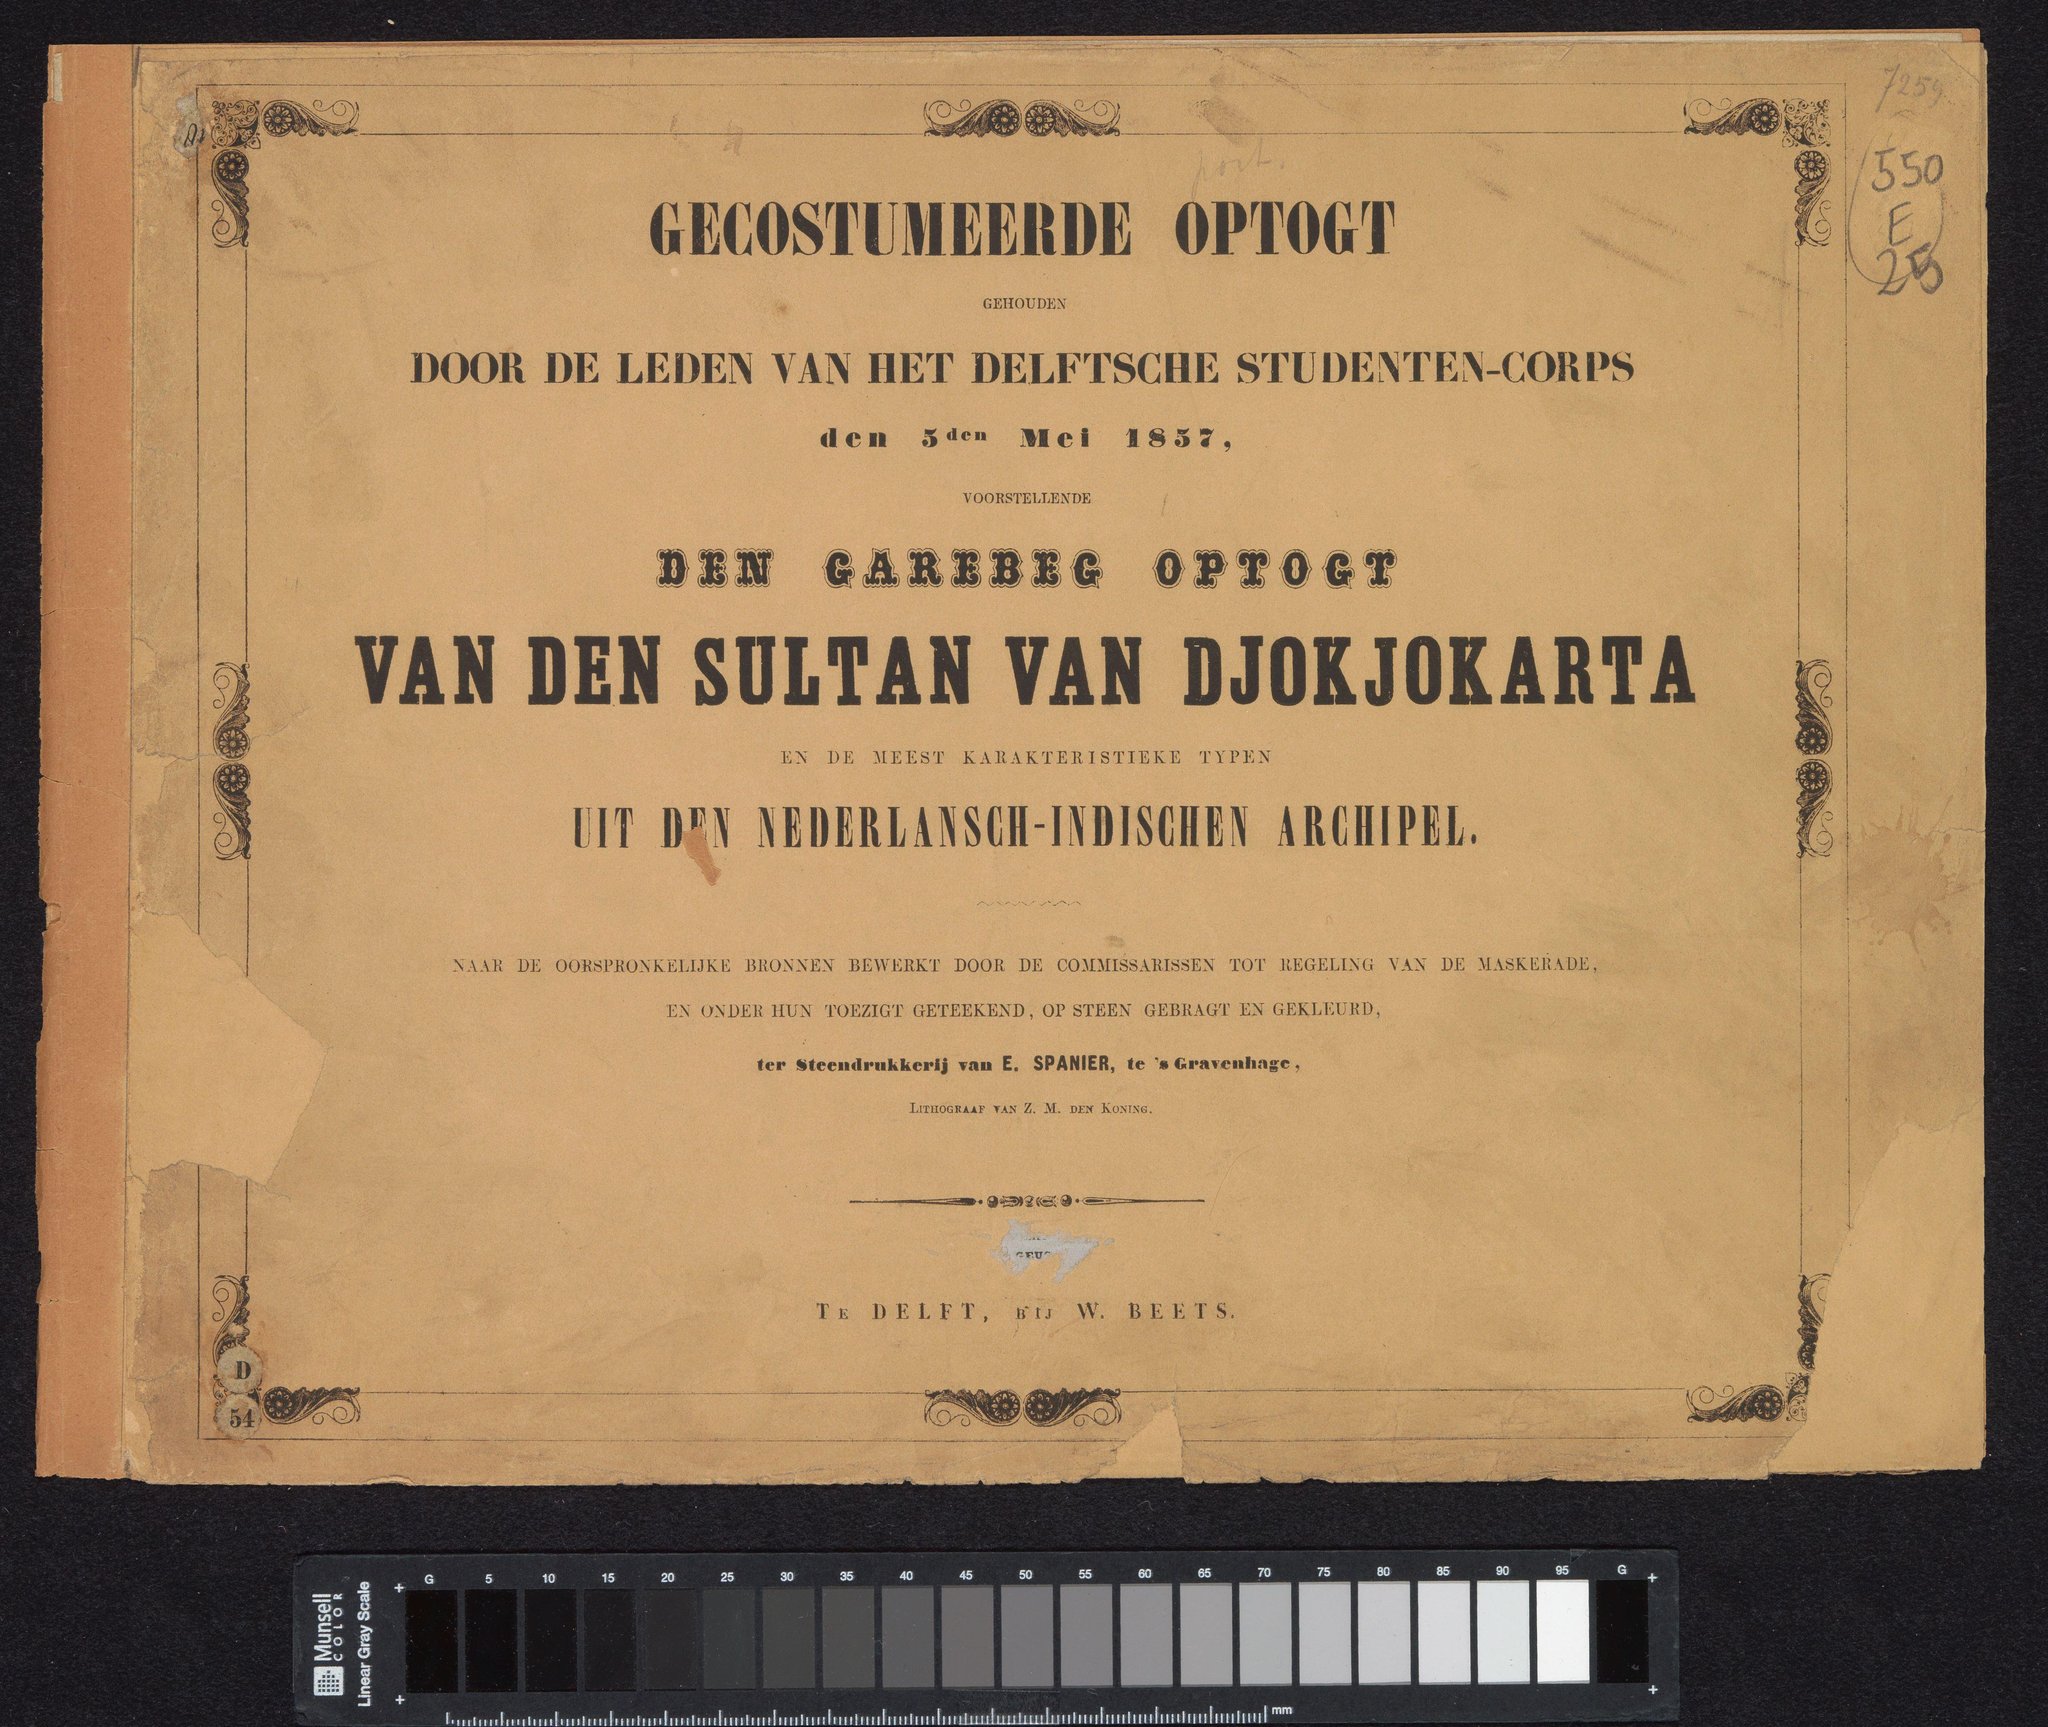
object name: text sheet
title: Omslag voor de maskerade van de Delftse studenten, 1857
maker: w. beets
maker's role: publisher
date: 1857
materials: paper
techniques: lithograph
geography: delft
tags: delft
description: Historische gekostumeerde optocht van de studenten van de Koninklijke Akademie te Delft op 5 mei 1857. De optocht verbeeldt de Garebeg optocht van de sultan van Djokjakarta plus verschillende karakteristieke types uit de Indonesische archipel. Binnen de omslag twee bladen met een toelichting en de legenda voor de serie van acht en een half aanelkaar geplakte bladen.